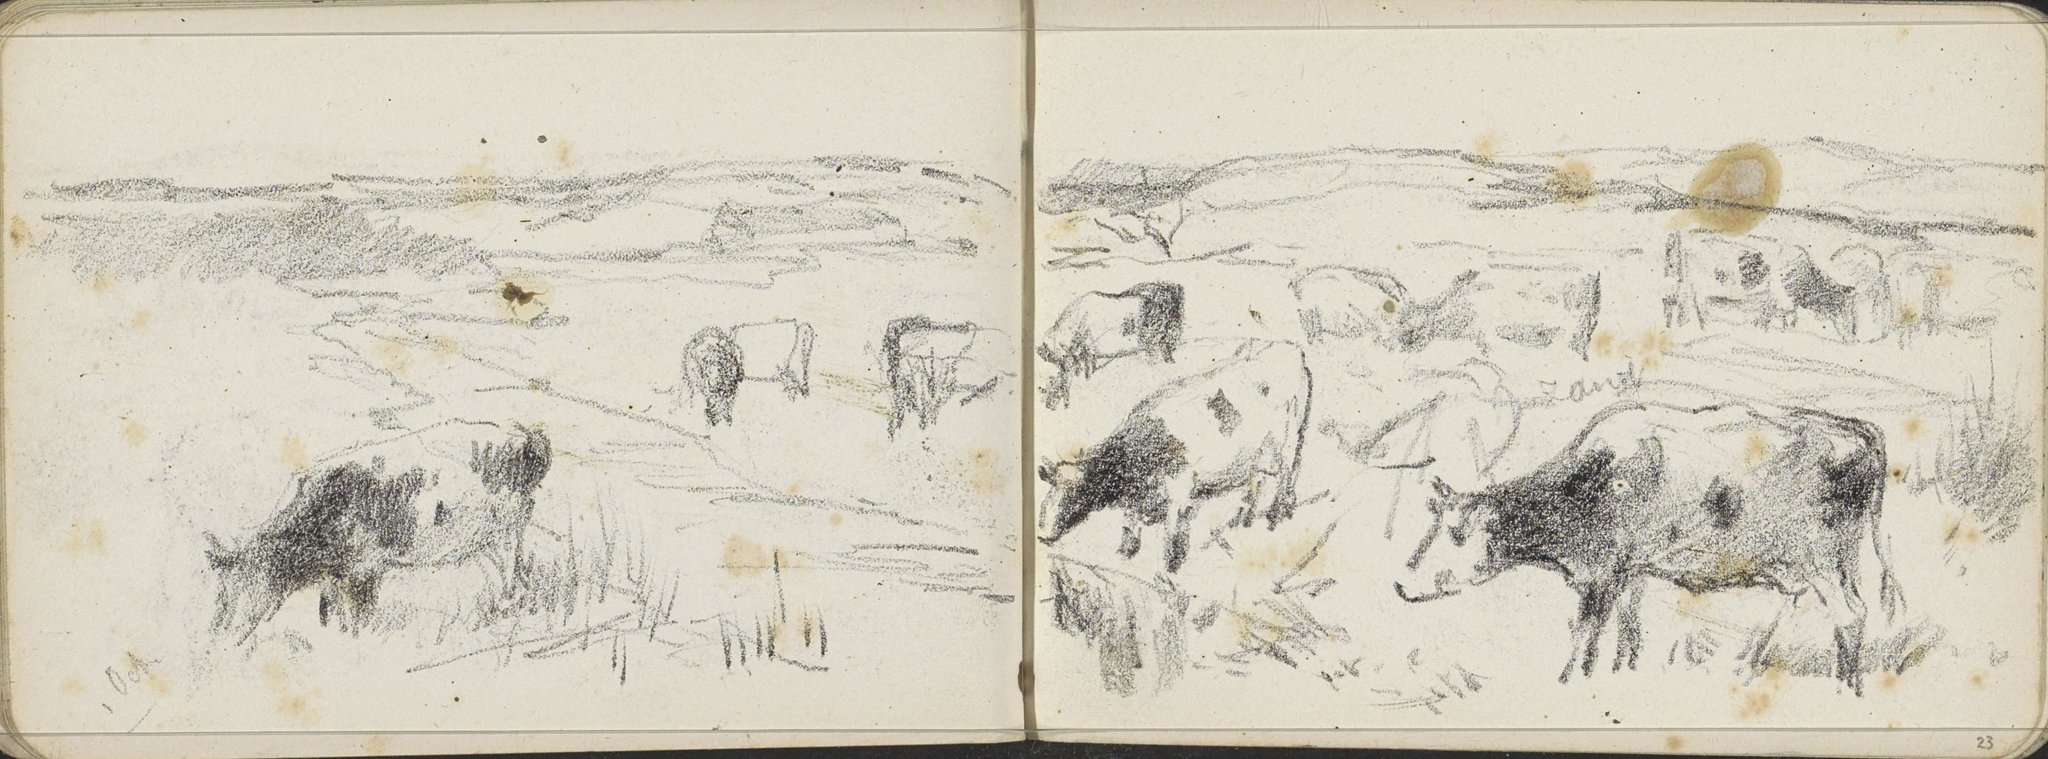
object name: sketchbook leaf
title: Koeien in een heuvellandschap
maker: willem cornelis rip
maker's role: draughtsman, painter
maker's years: 1856-1922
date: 1907-1910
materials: chalk, paper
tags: low hill country, cow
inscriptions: date and inscription: ‘1 Oct/ zand’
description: Blad 22 verso en 23 recto uit een schetsboek met 41 bladen.